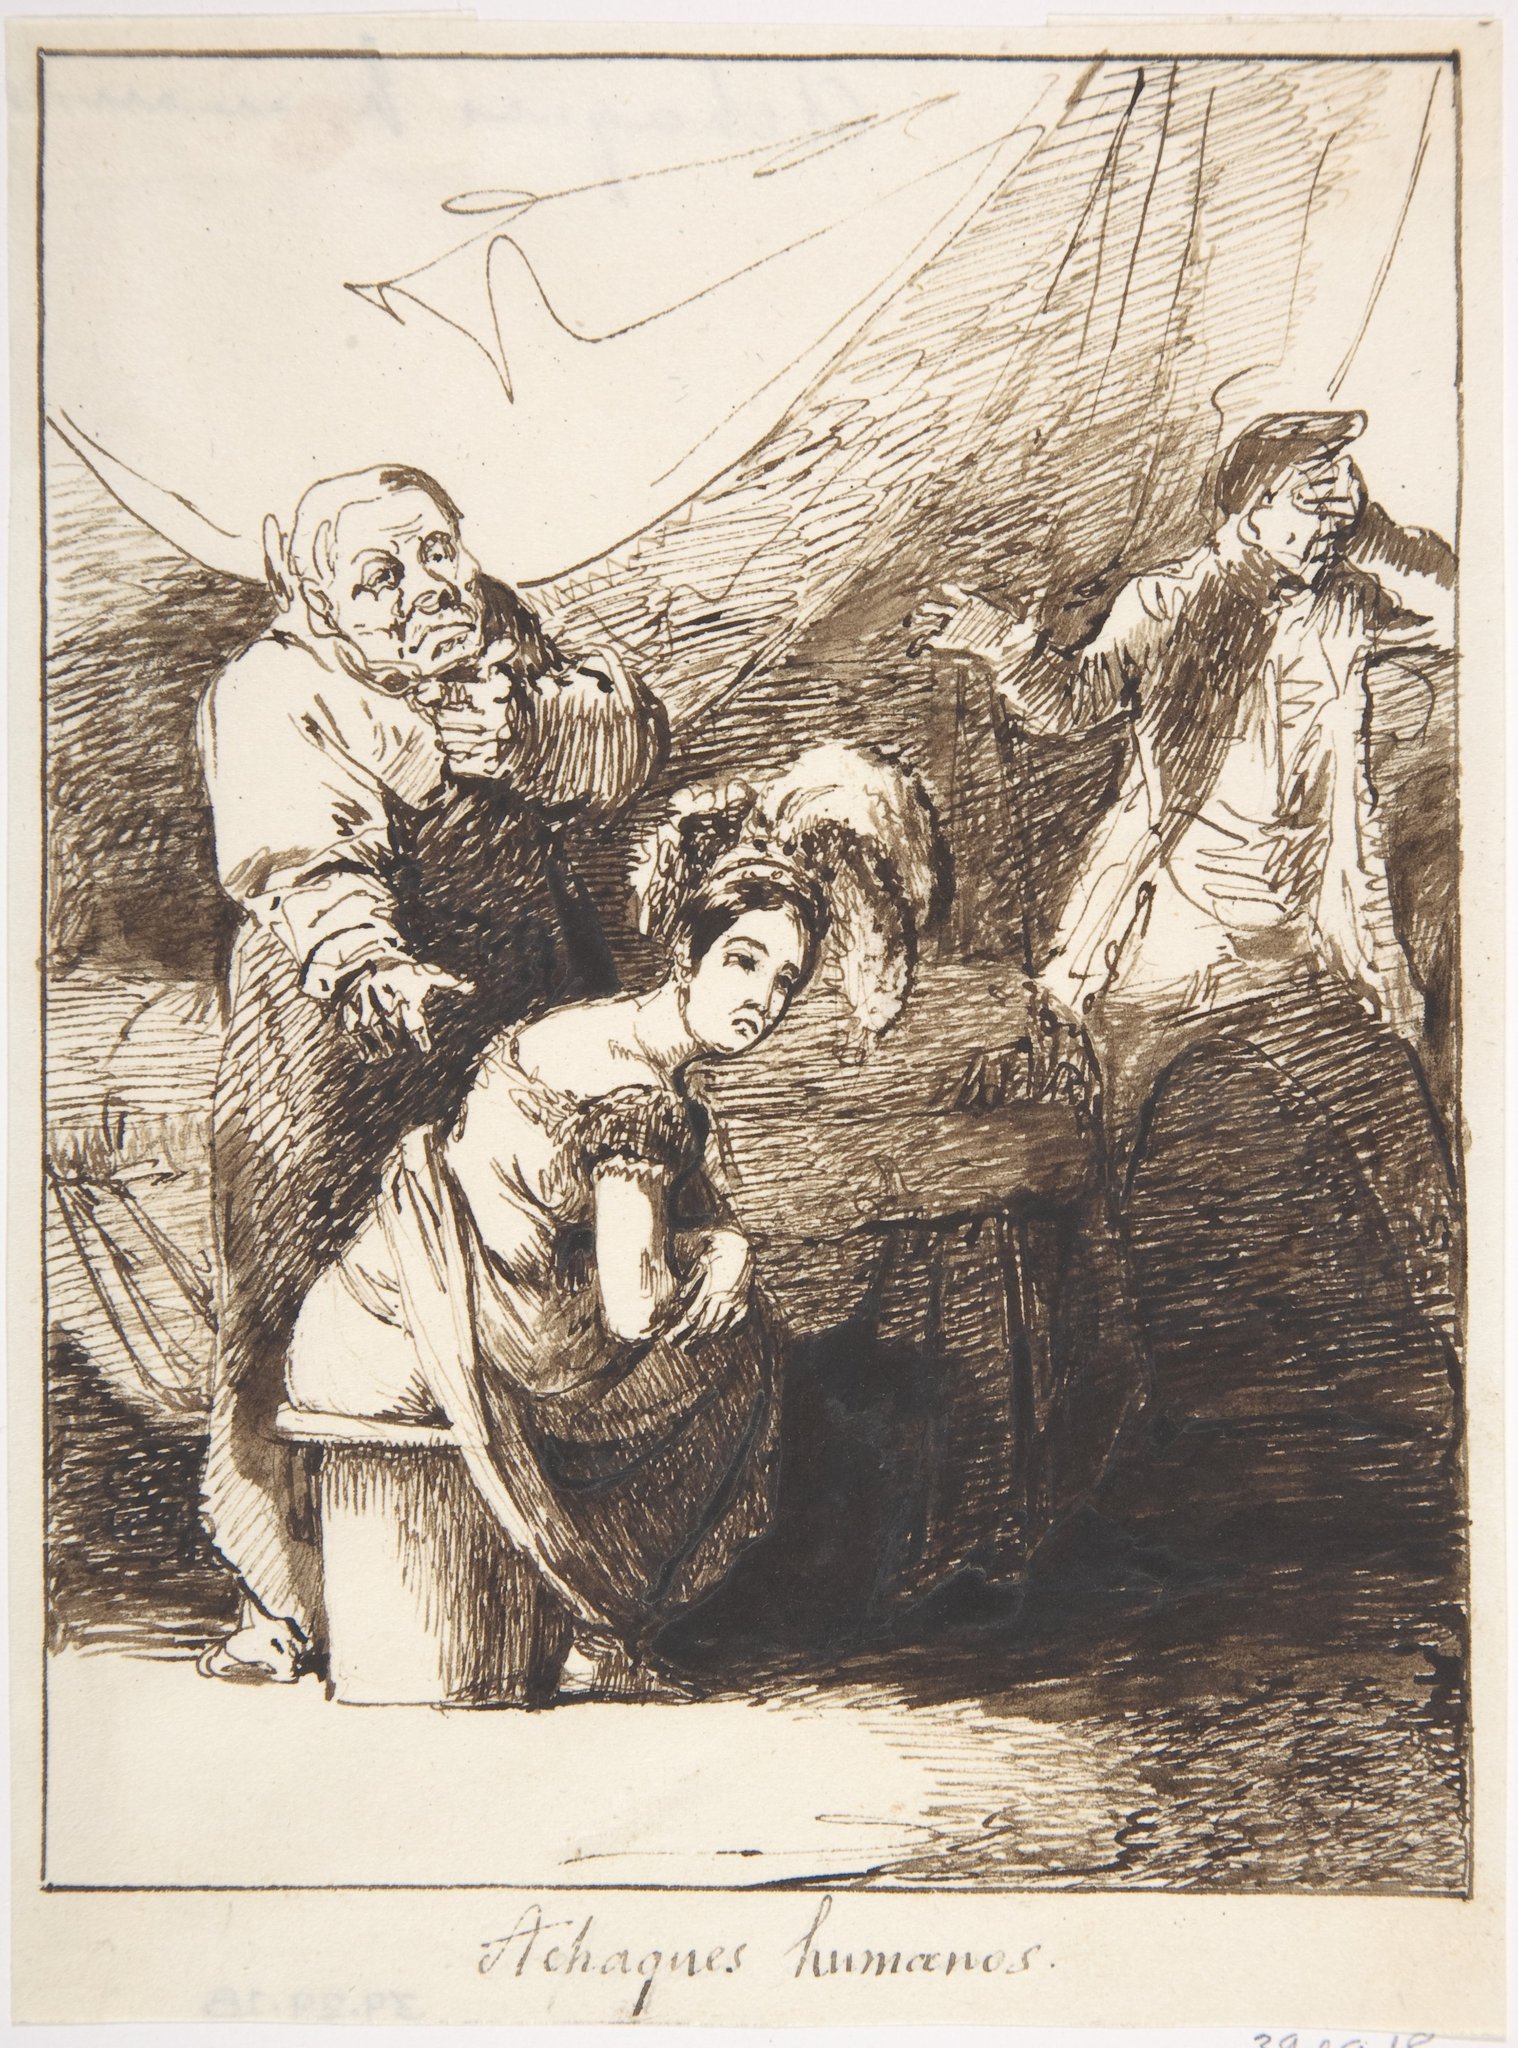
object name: drawing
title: Human Ailments (Achaques humanos)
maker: leonardo alenza y nieto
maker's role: artist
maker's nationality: spanish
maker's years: 1807-1845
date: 1807-1845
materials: ink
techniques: brush, pen, wash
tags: illness,men,women